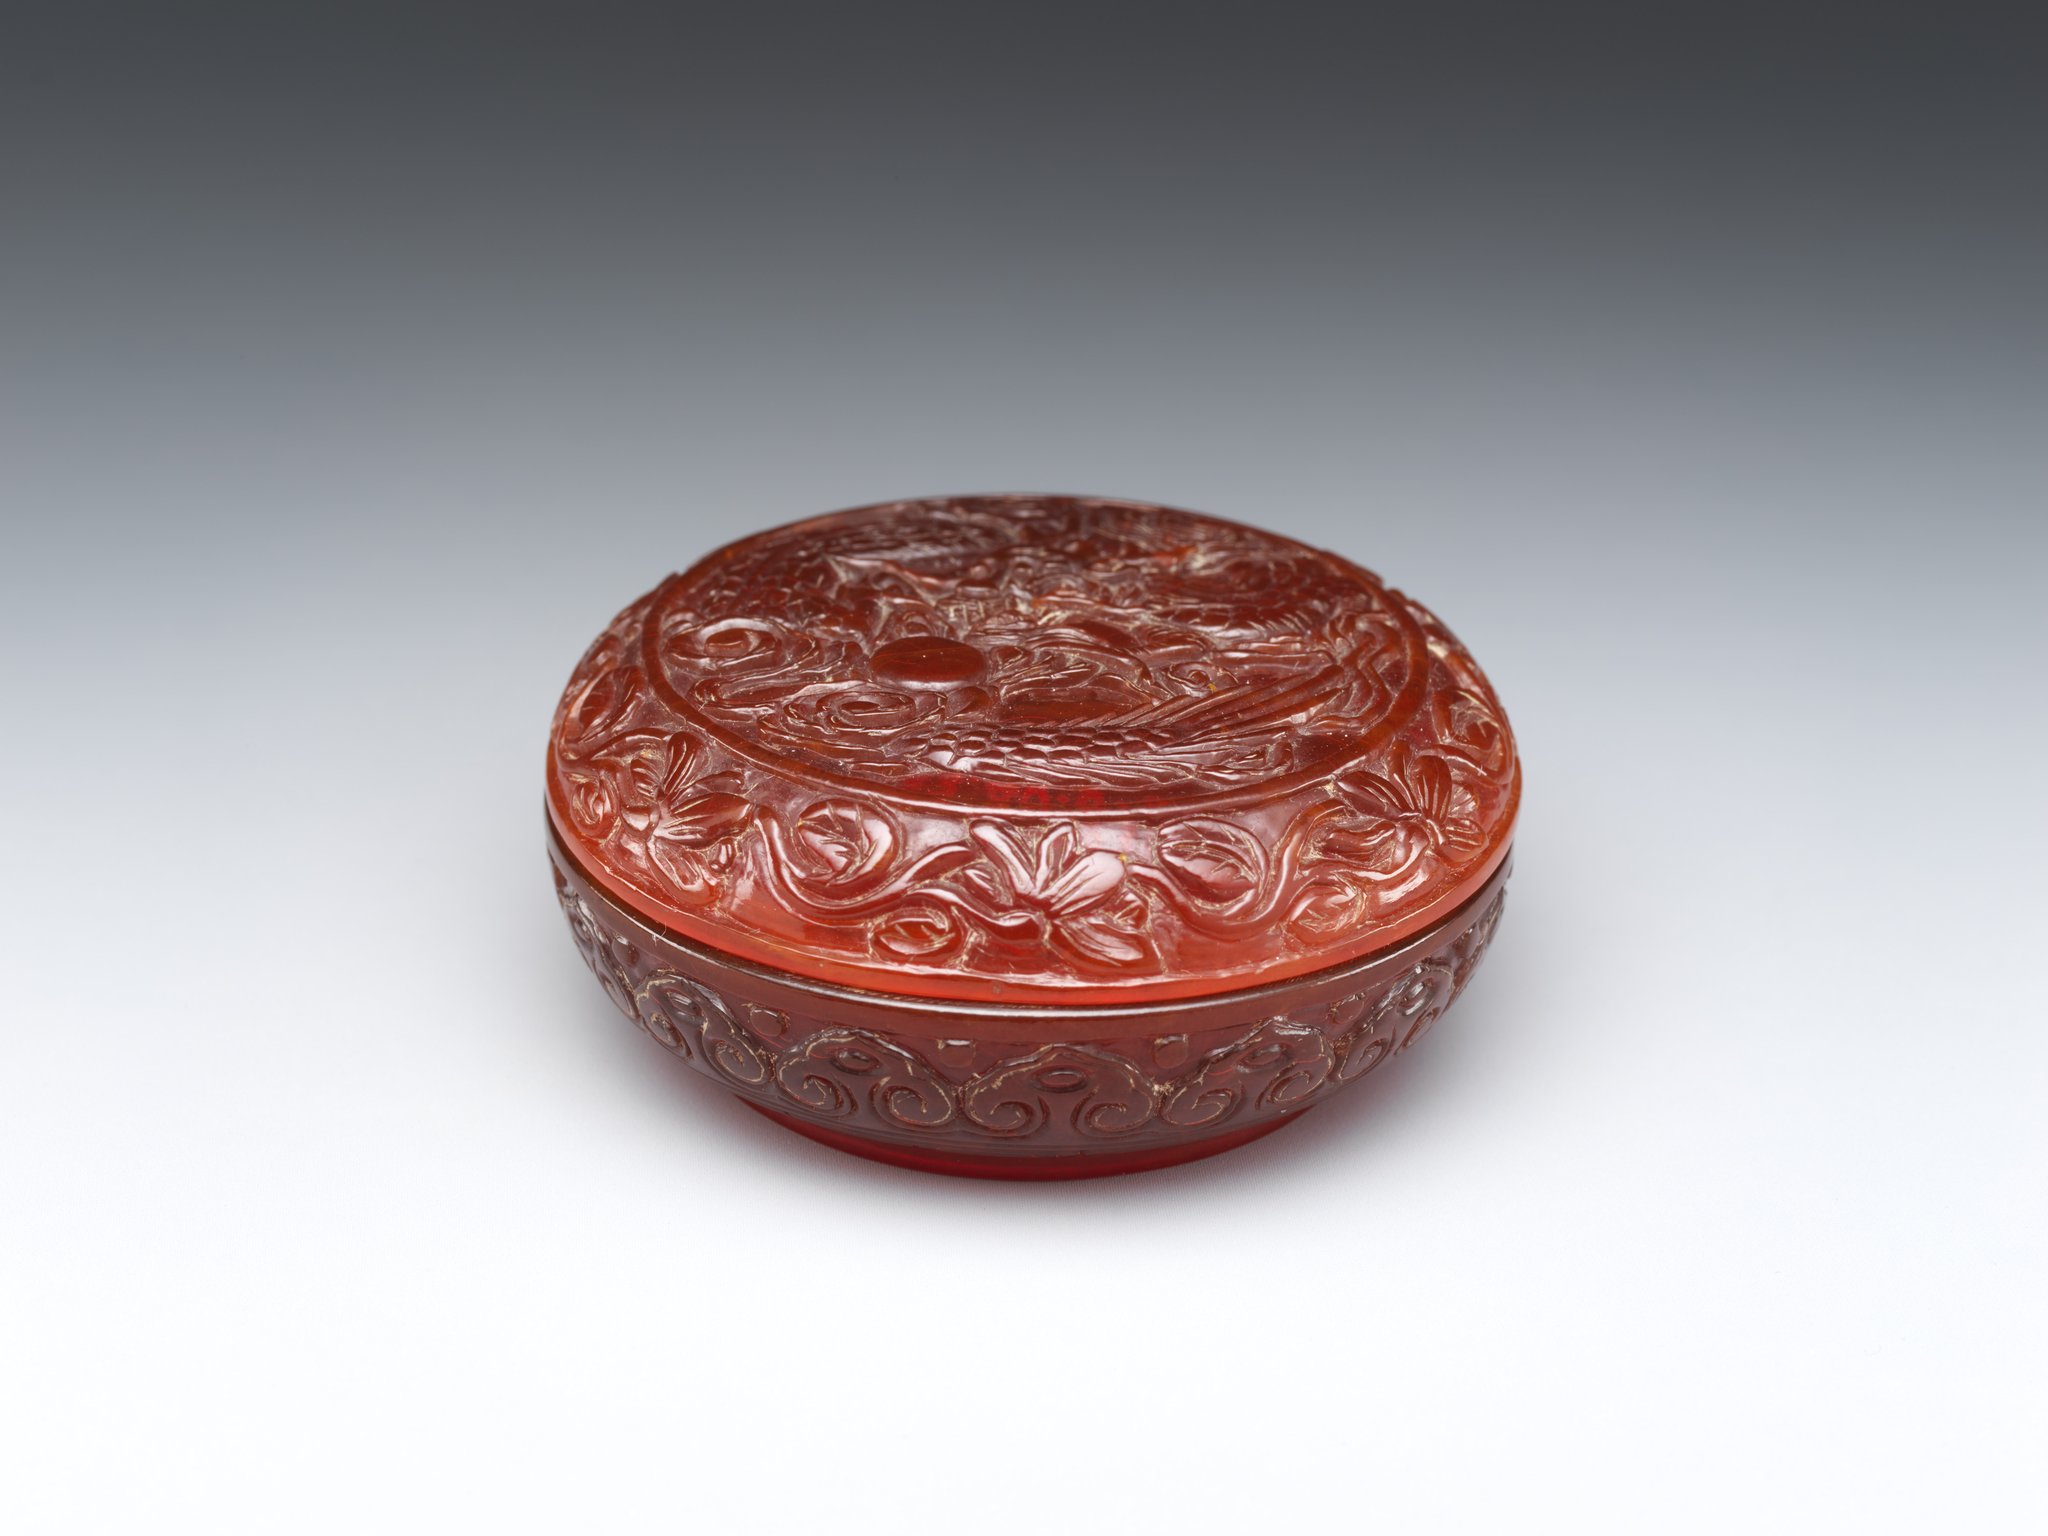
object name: box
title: Covered Box with Dragon Chasing Pearl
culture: chinese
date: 1644-1911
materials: amber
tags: leaves